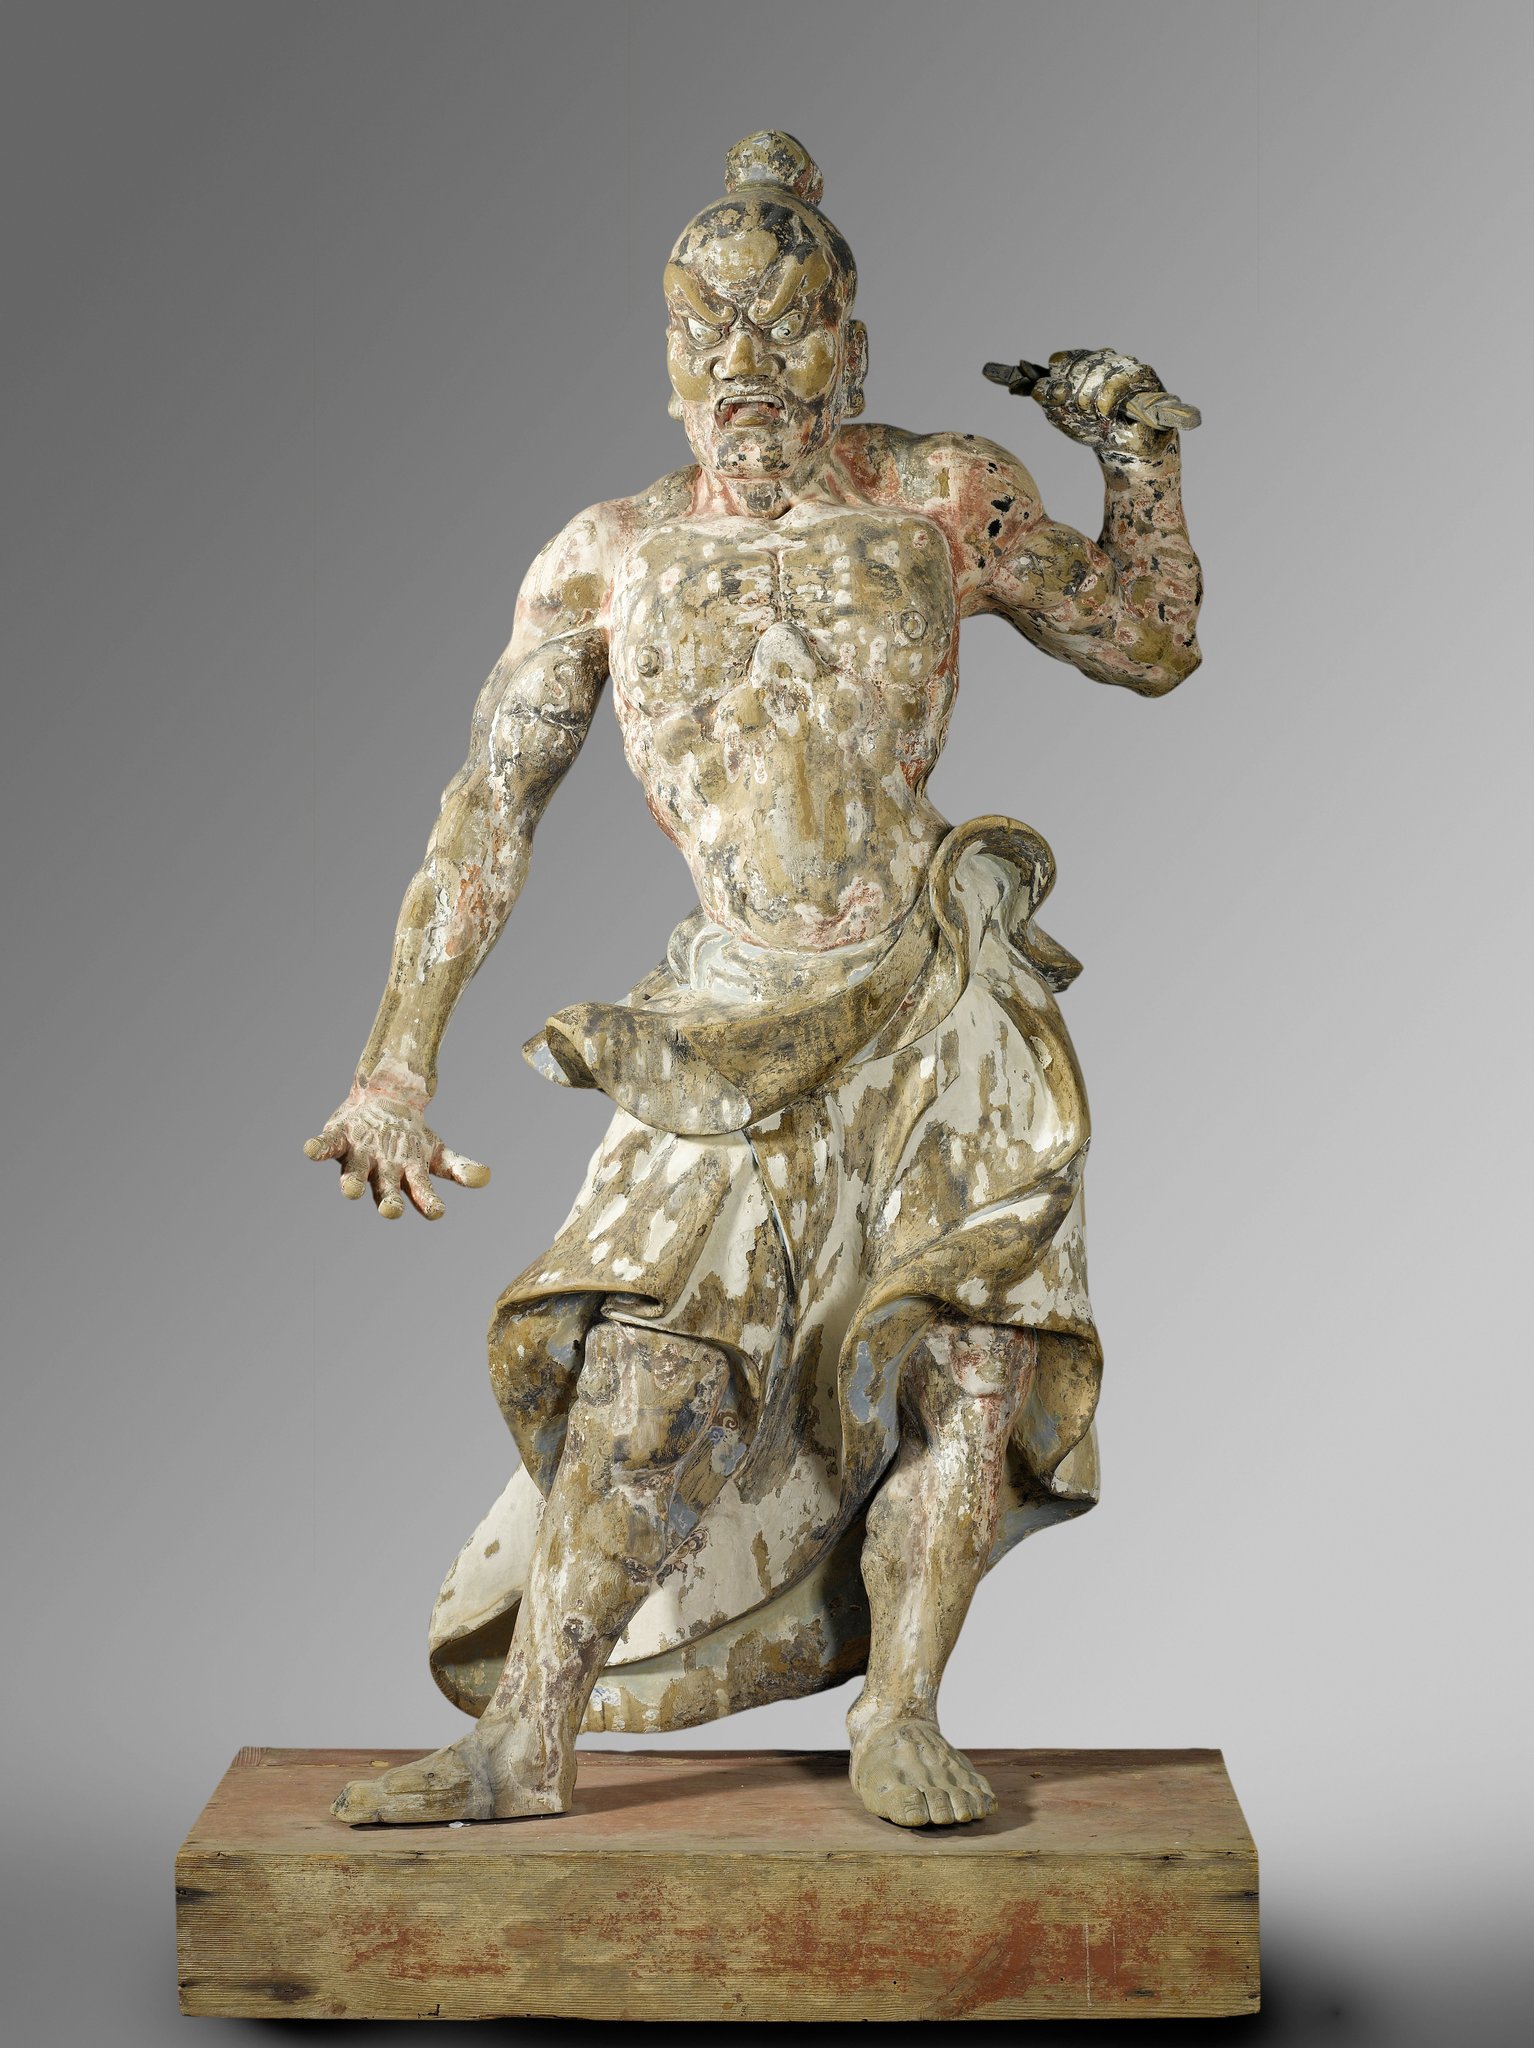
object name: sculpture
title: Temple Guardian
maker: Anonymous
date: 1300-1400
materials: wood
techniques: polychromy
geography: japan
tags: temple watch ~ non-christian religions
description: De tempelwachters (AK-RAK-2007-1-A/B) stonden bij de ingang van de tempel Iwayaji in de West-Japanse prefectuur Shimane.